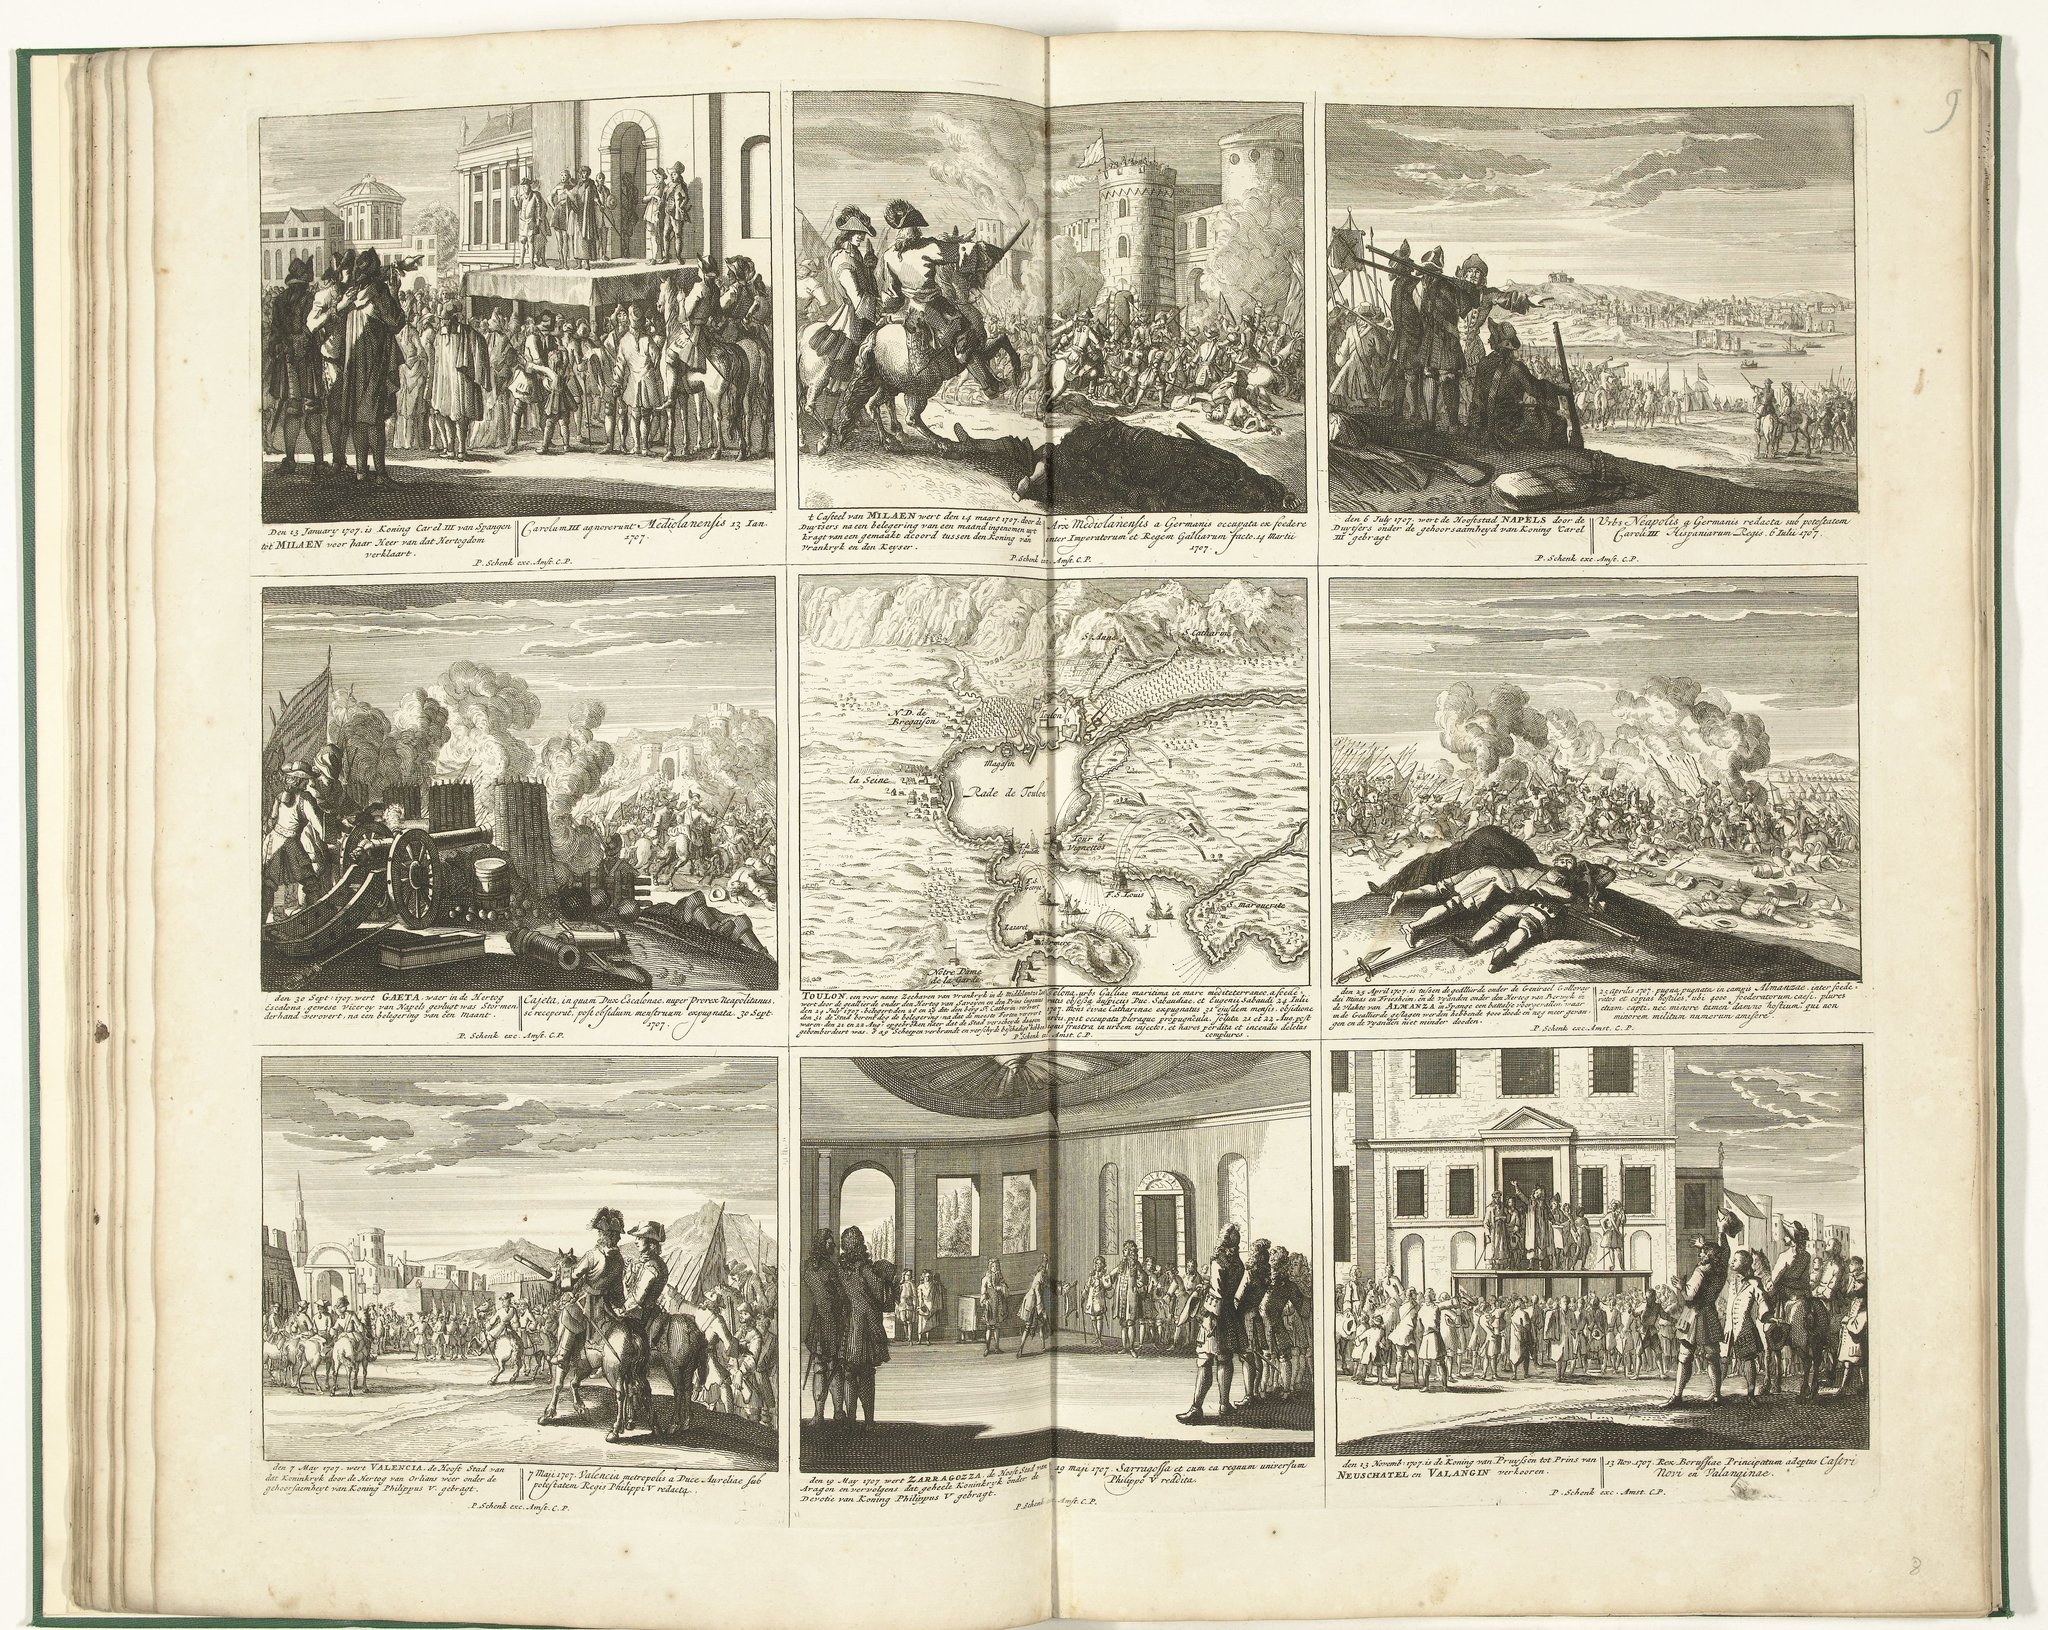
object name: print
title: Schouwburg van den oorlog (blad VIII), 1707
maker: pieter schenk (i)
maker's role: print maker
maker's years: 1660-1711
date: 1707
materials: paper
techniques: etching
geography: amsterdam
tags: battle (+ land forces), naples, toulon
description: Blad met negen voorstellingen van gebeurtenissen uit het jaar 1707 van de Spaanse Successieoorlog en van plattegronden van versterkte steden. Blad VIII in: Schouwburg van den oorlog (editie van 1720), het prentwerk met de gebundelde reeks van 31 platen over de Spaanse Successieoorlog.